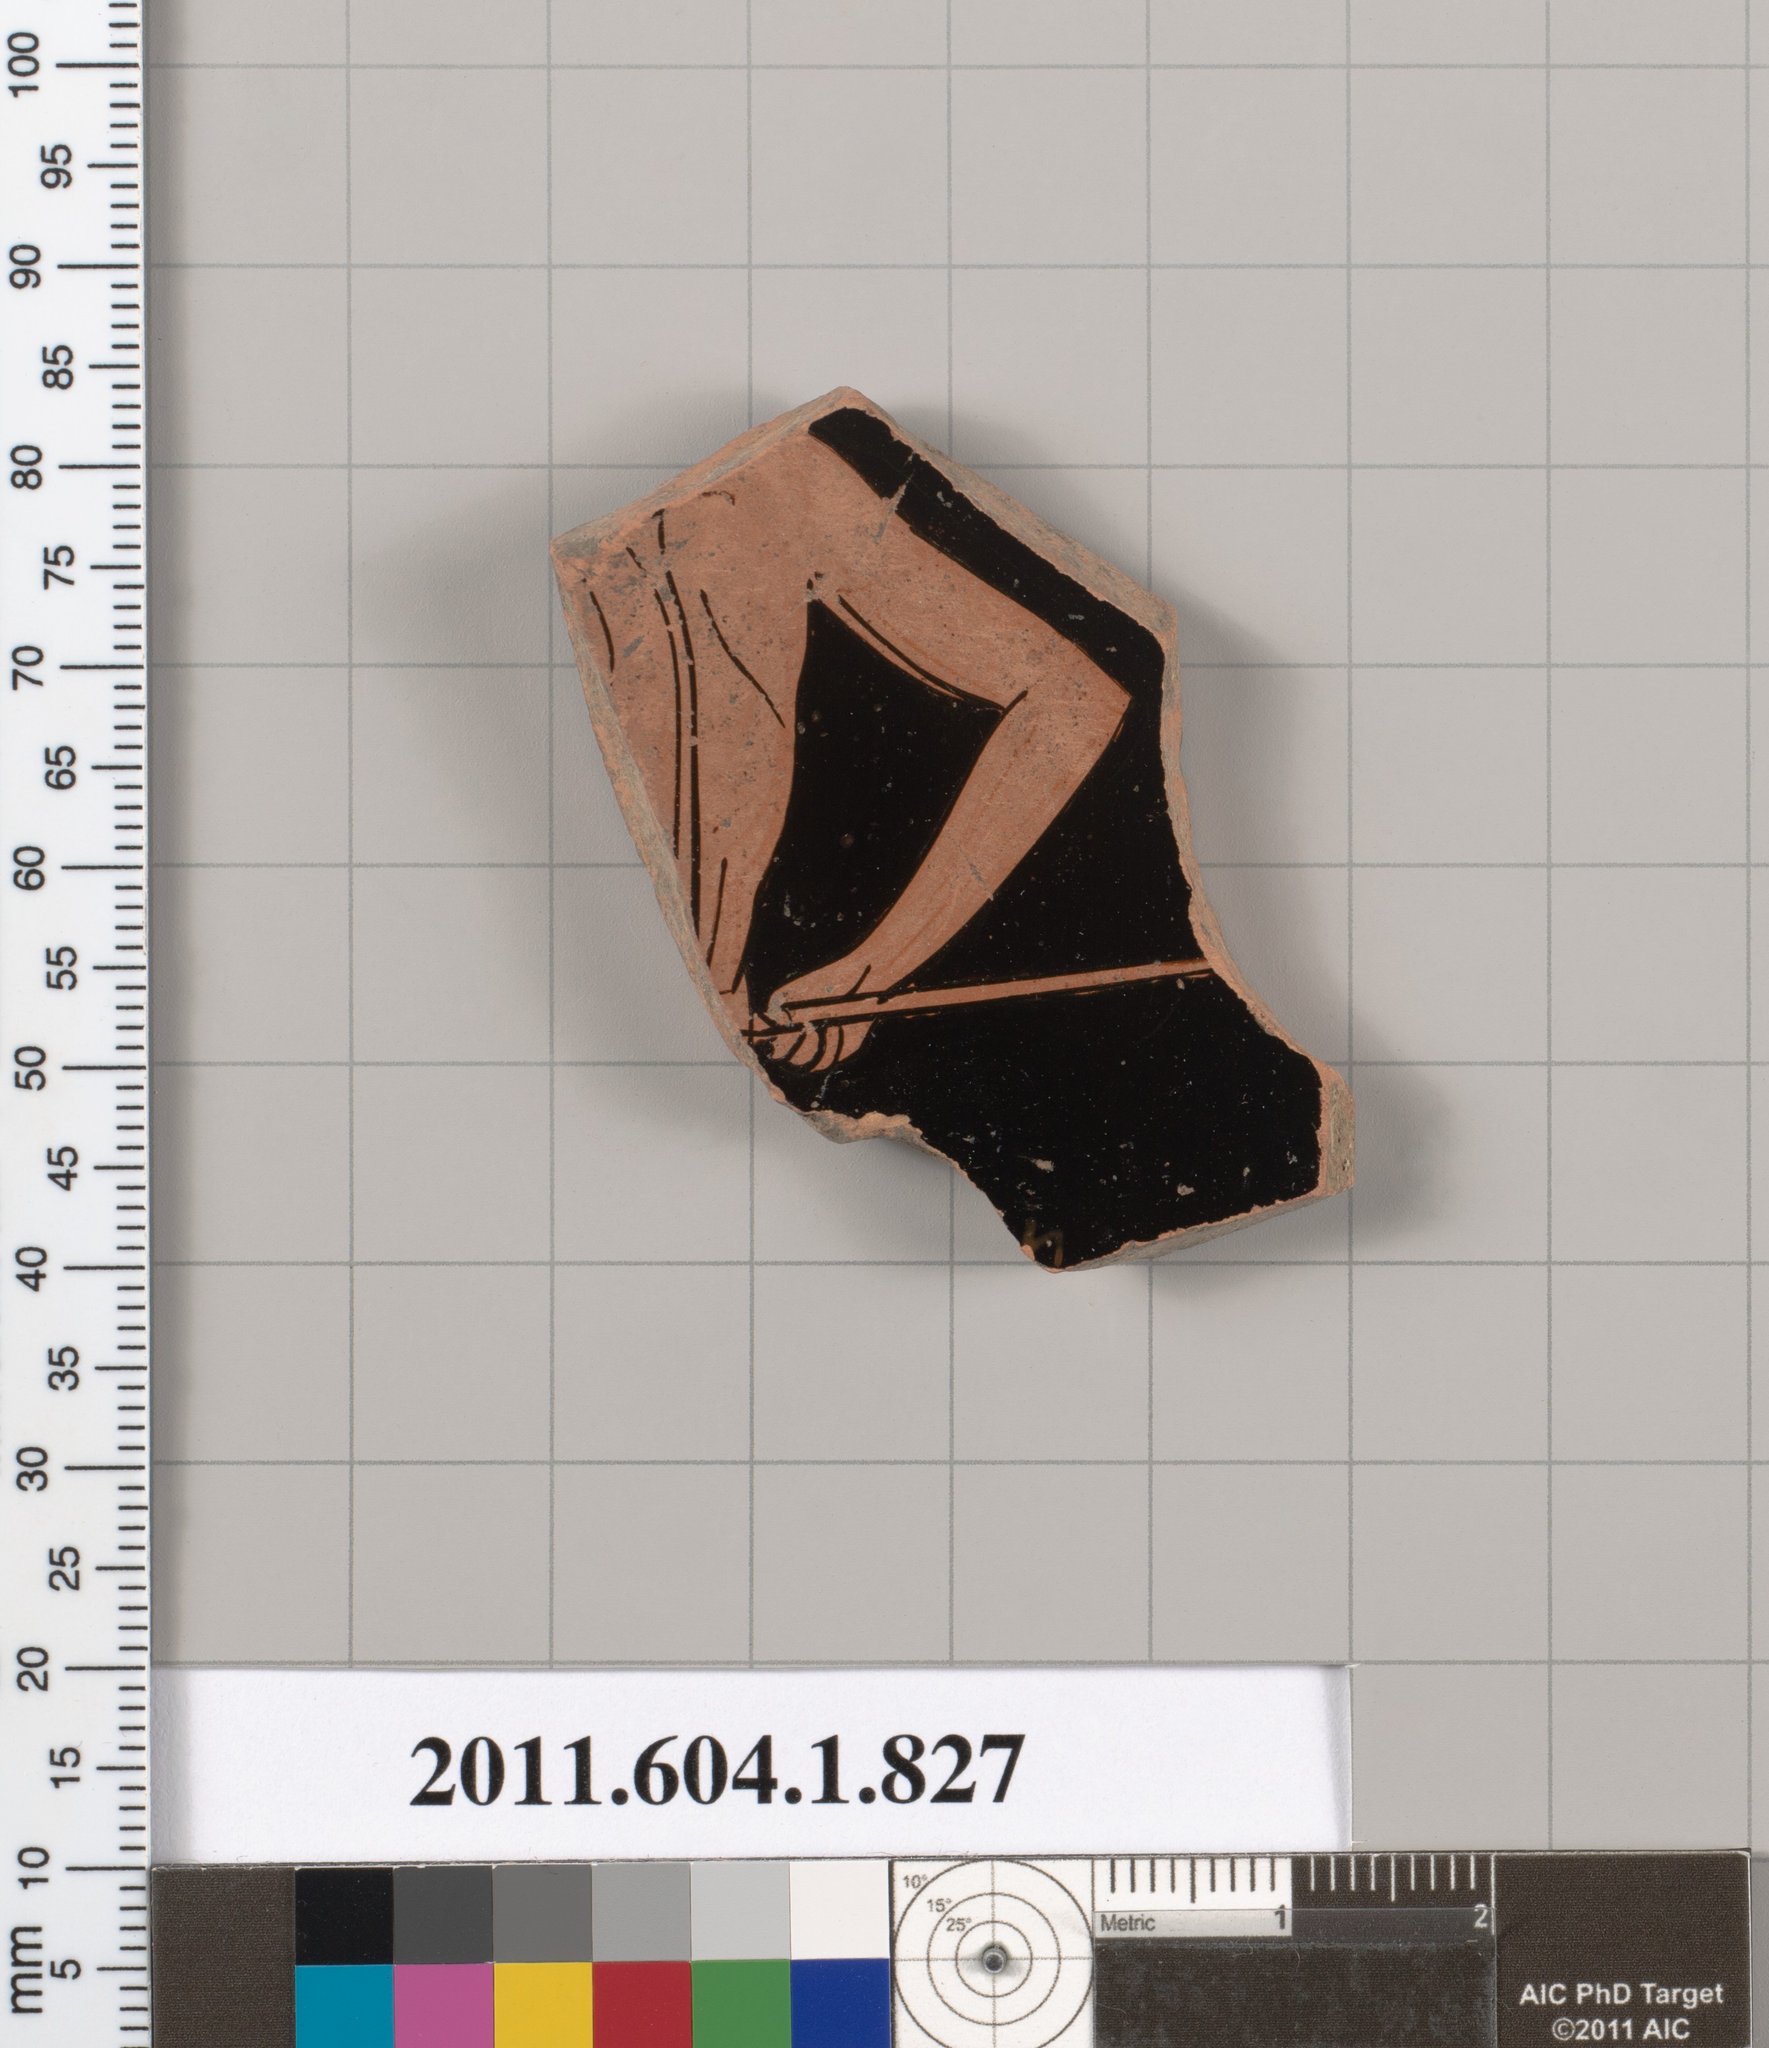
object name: kylix fragment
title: Terracotta fragment of a kylix (drinking cup)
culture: greek, attic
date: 490-480 BCE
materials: terracotta